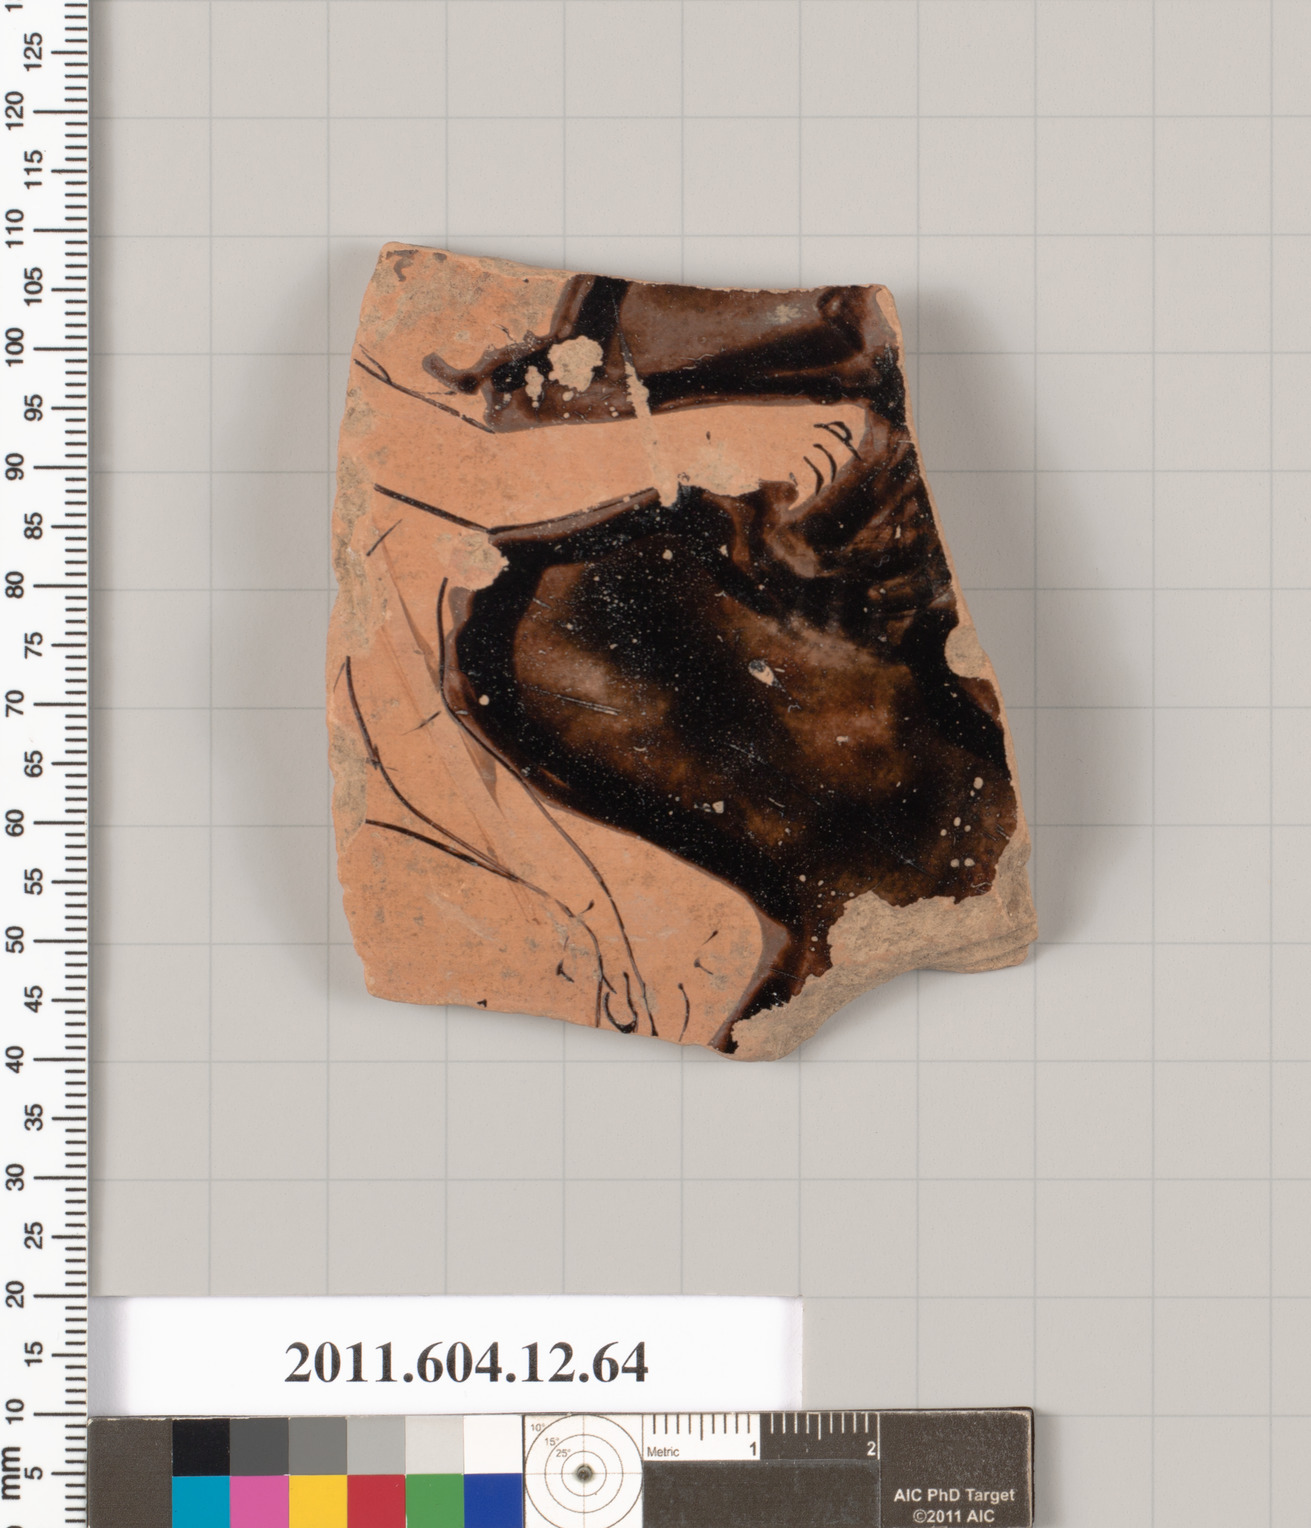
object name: undetermined closed shape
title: Terracotta fragment of a closed shape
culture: greek or south italian or campanian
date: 367-335 BCE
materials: terracotta